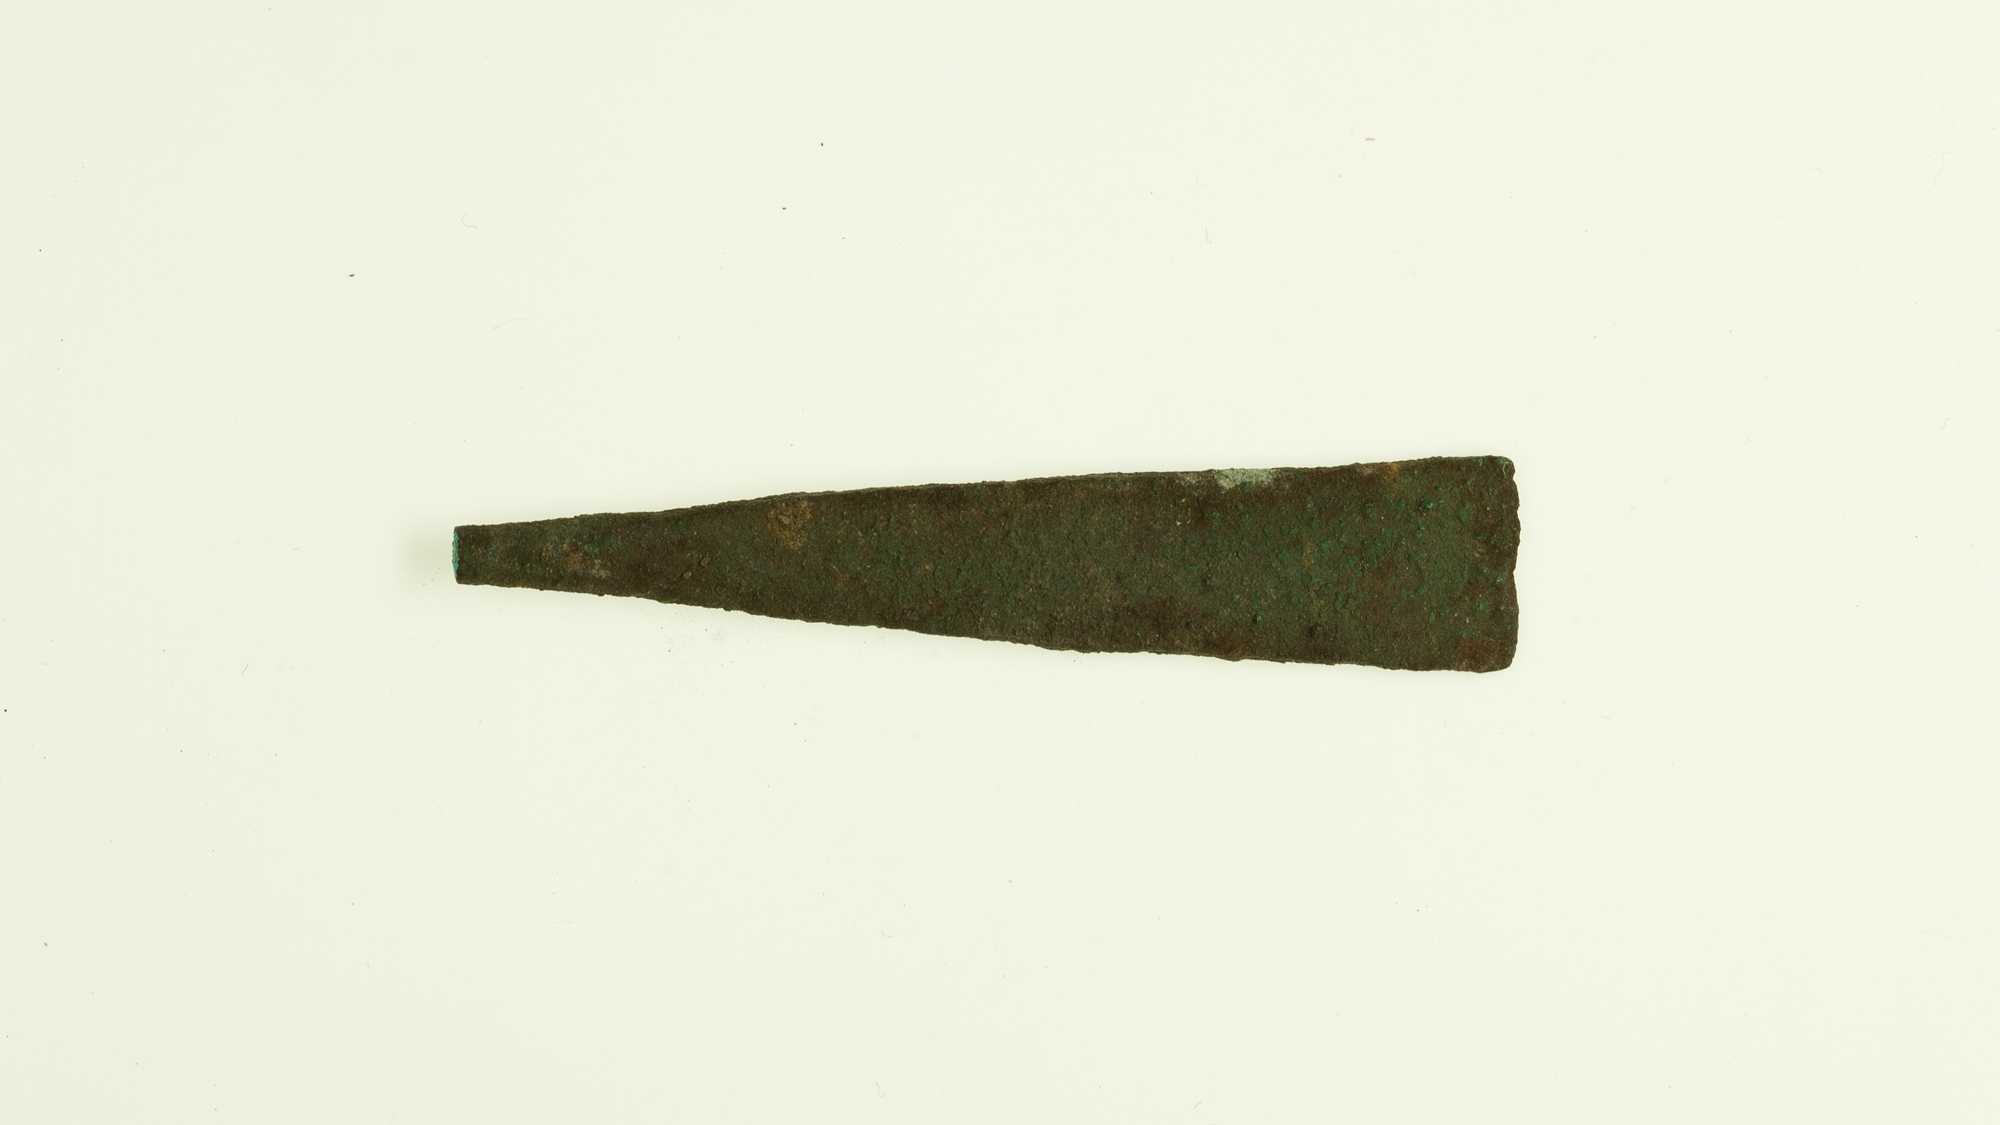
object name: chisel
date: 1295-1070 BCE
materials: bronze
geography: egypt